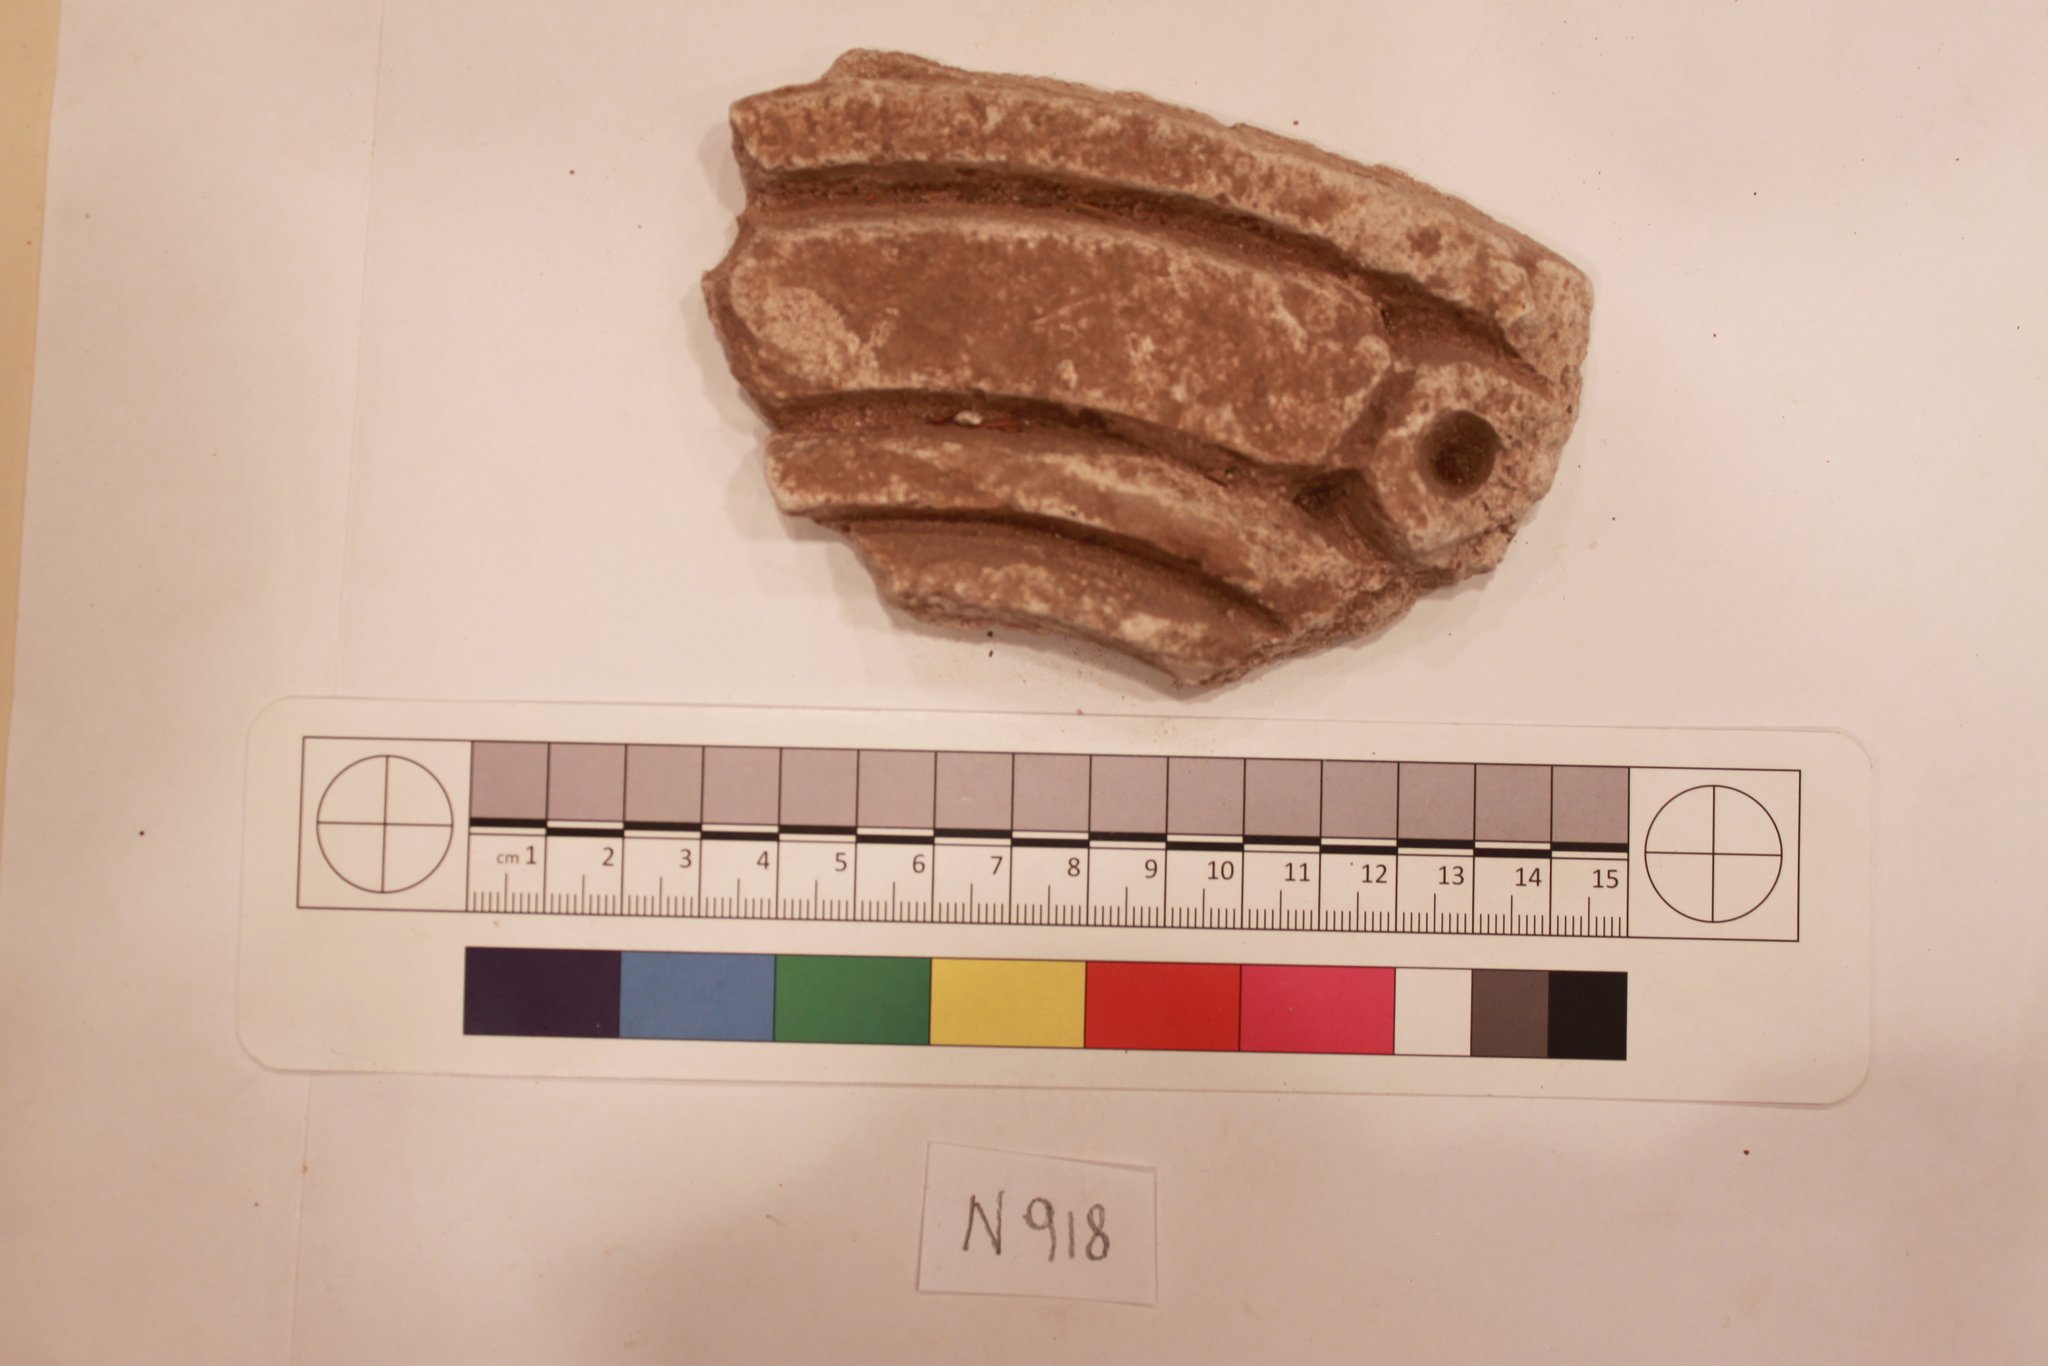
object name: fragment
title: Stucco Fragment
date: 701-1200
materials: plaster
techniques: carving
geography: iran